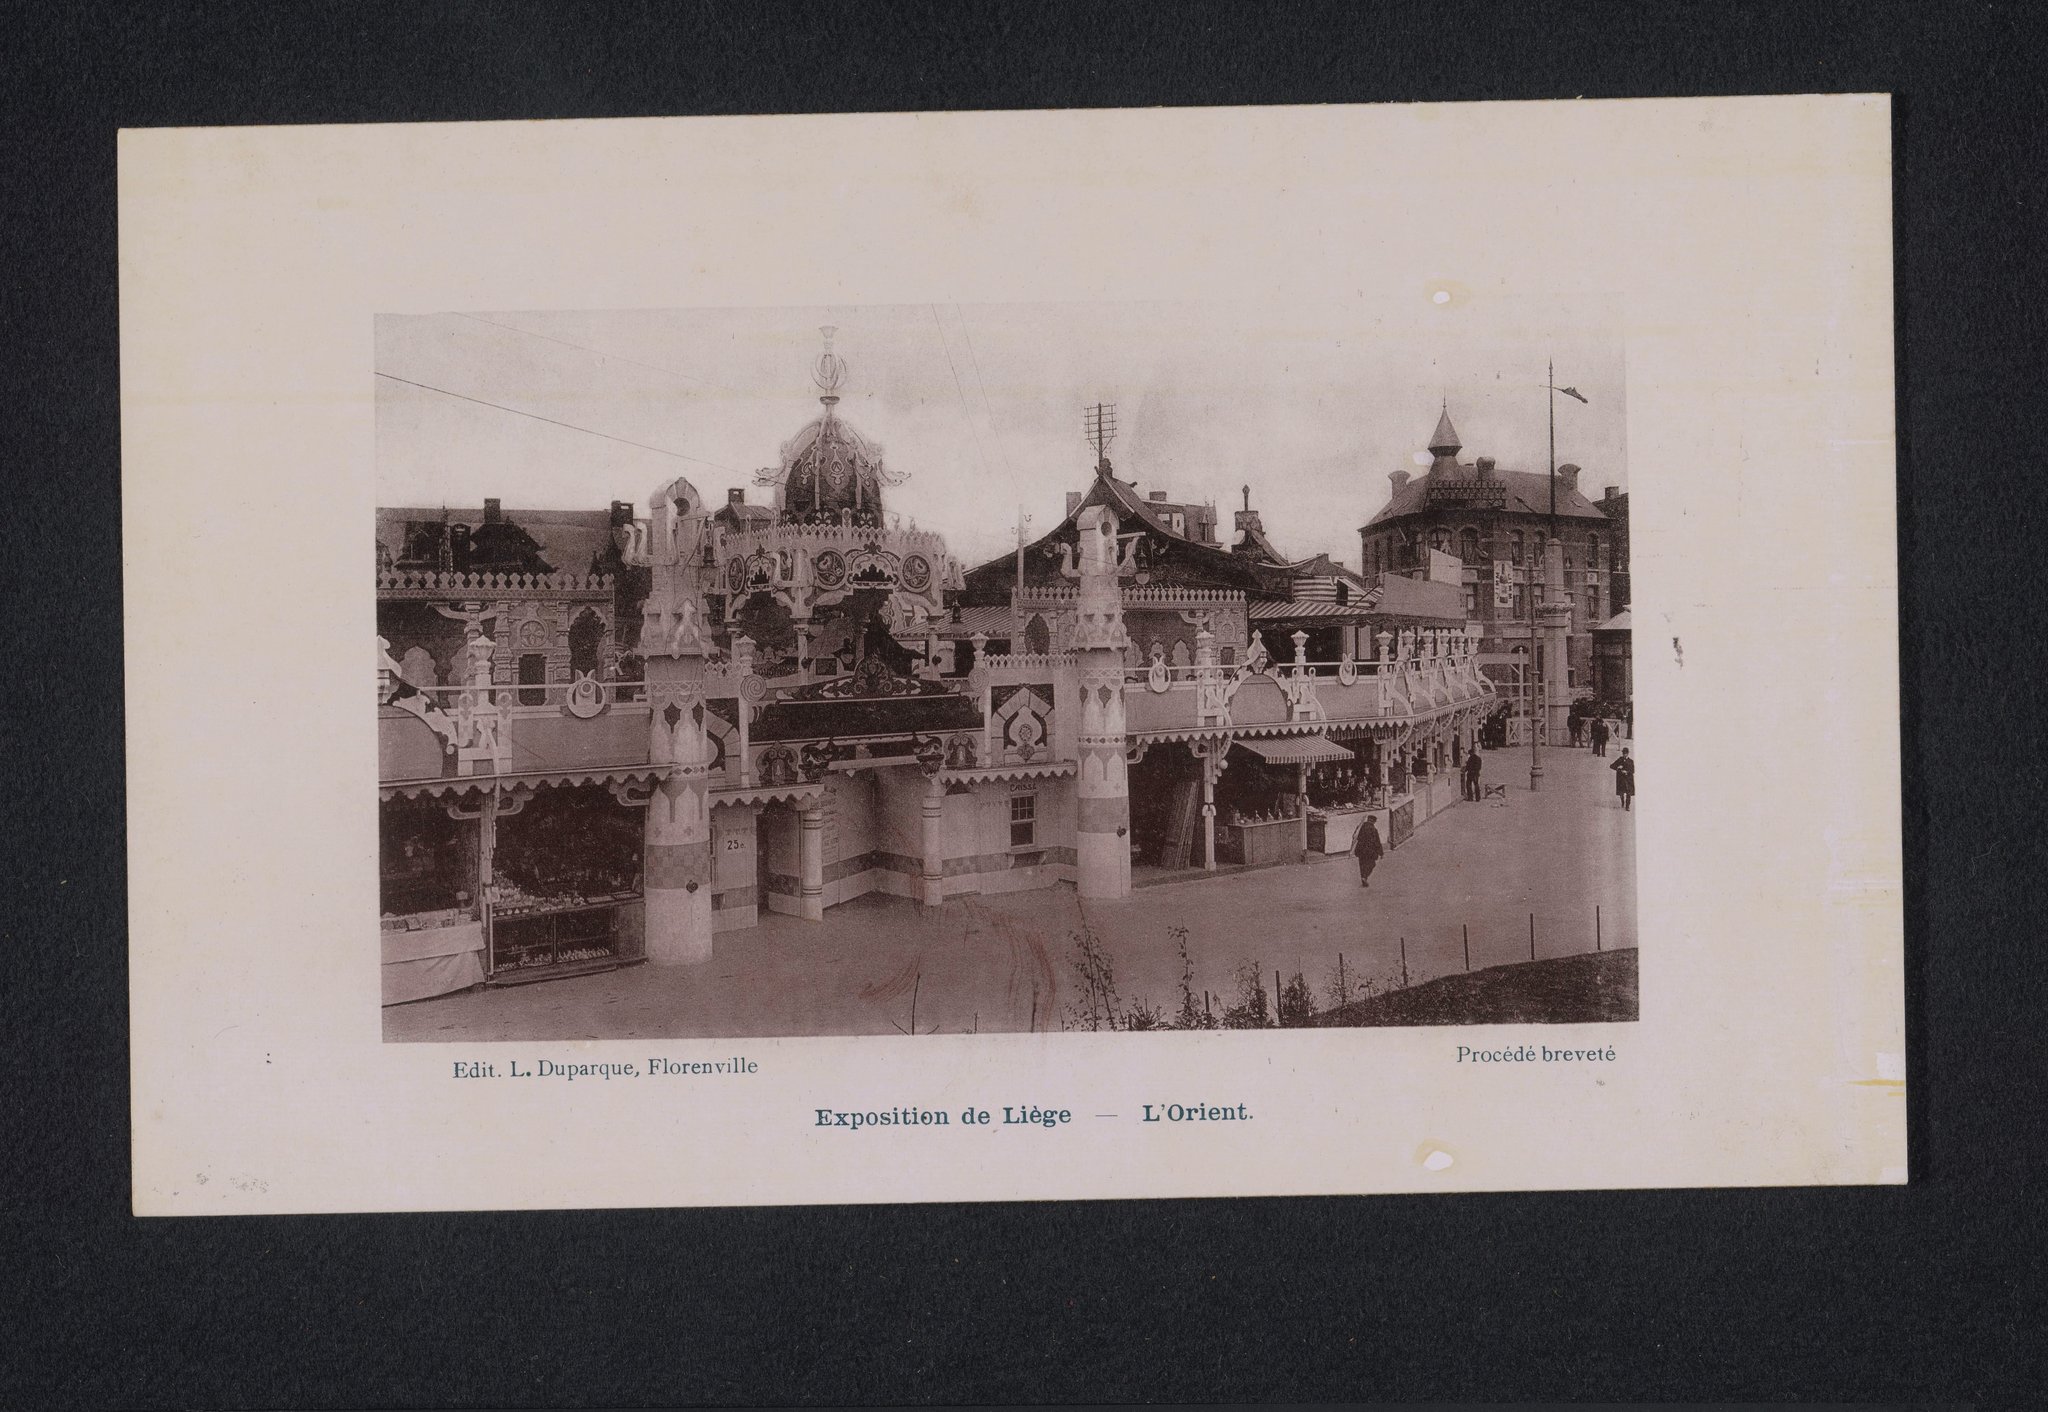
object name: photomechanical print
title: Gezicht op het Oosterse paviljoen van de Wereldtentoonstelling van 1905 in Luik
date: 1905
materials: paper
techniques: photograph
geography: florenville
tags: world fair, world exhibition, palace, liège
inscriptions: inscription: ‘Procédé breveté’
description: Deze prent maakt deel uit van een omslag met 16 prenten.